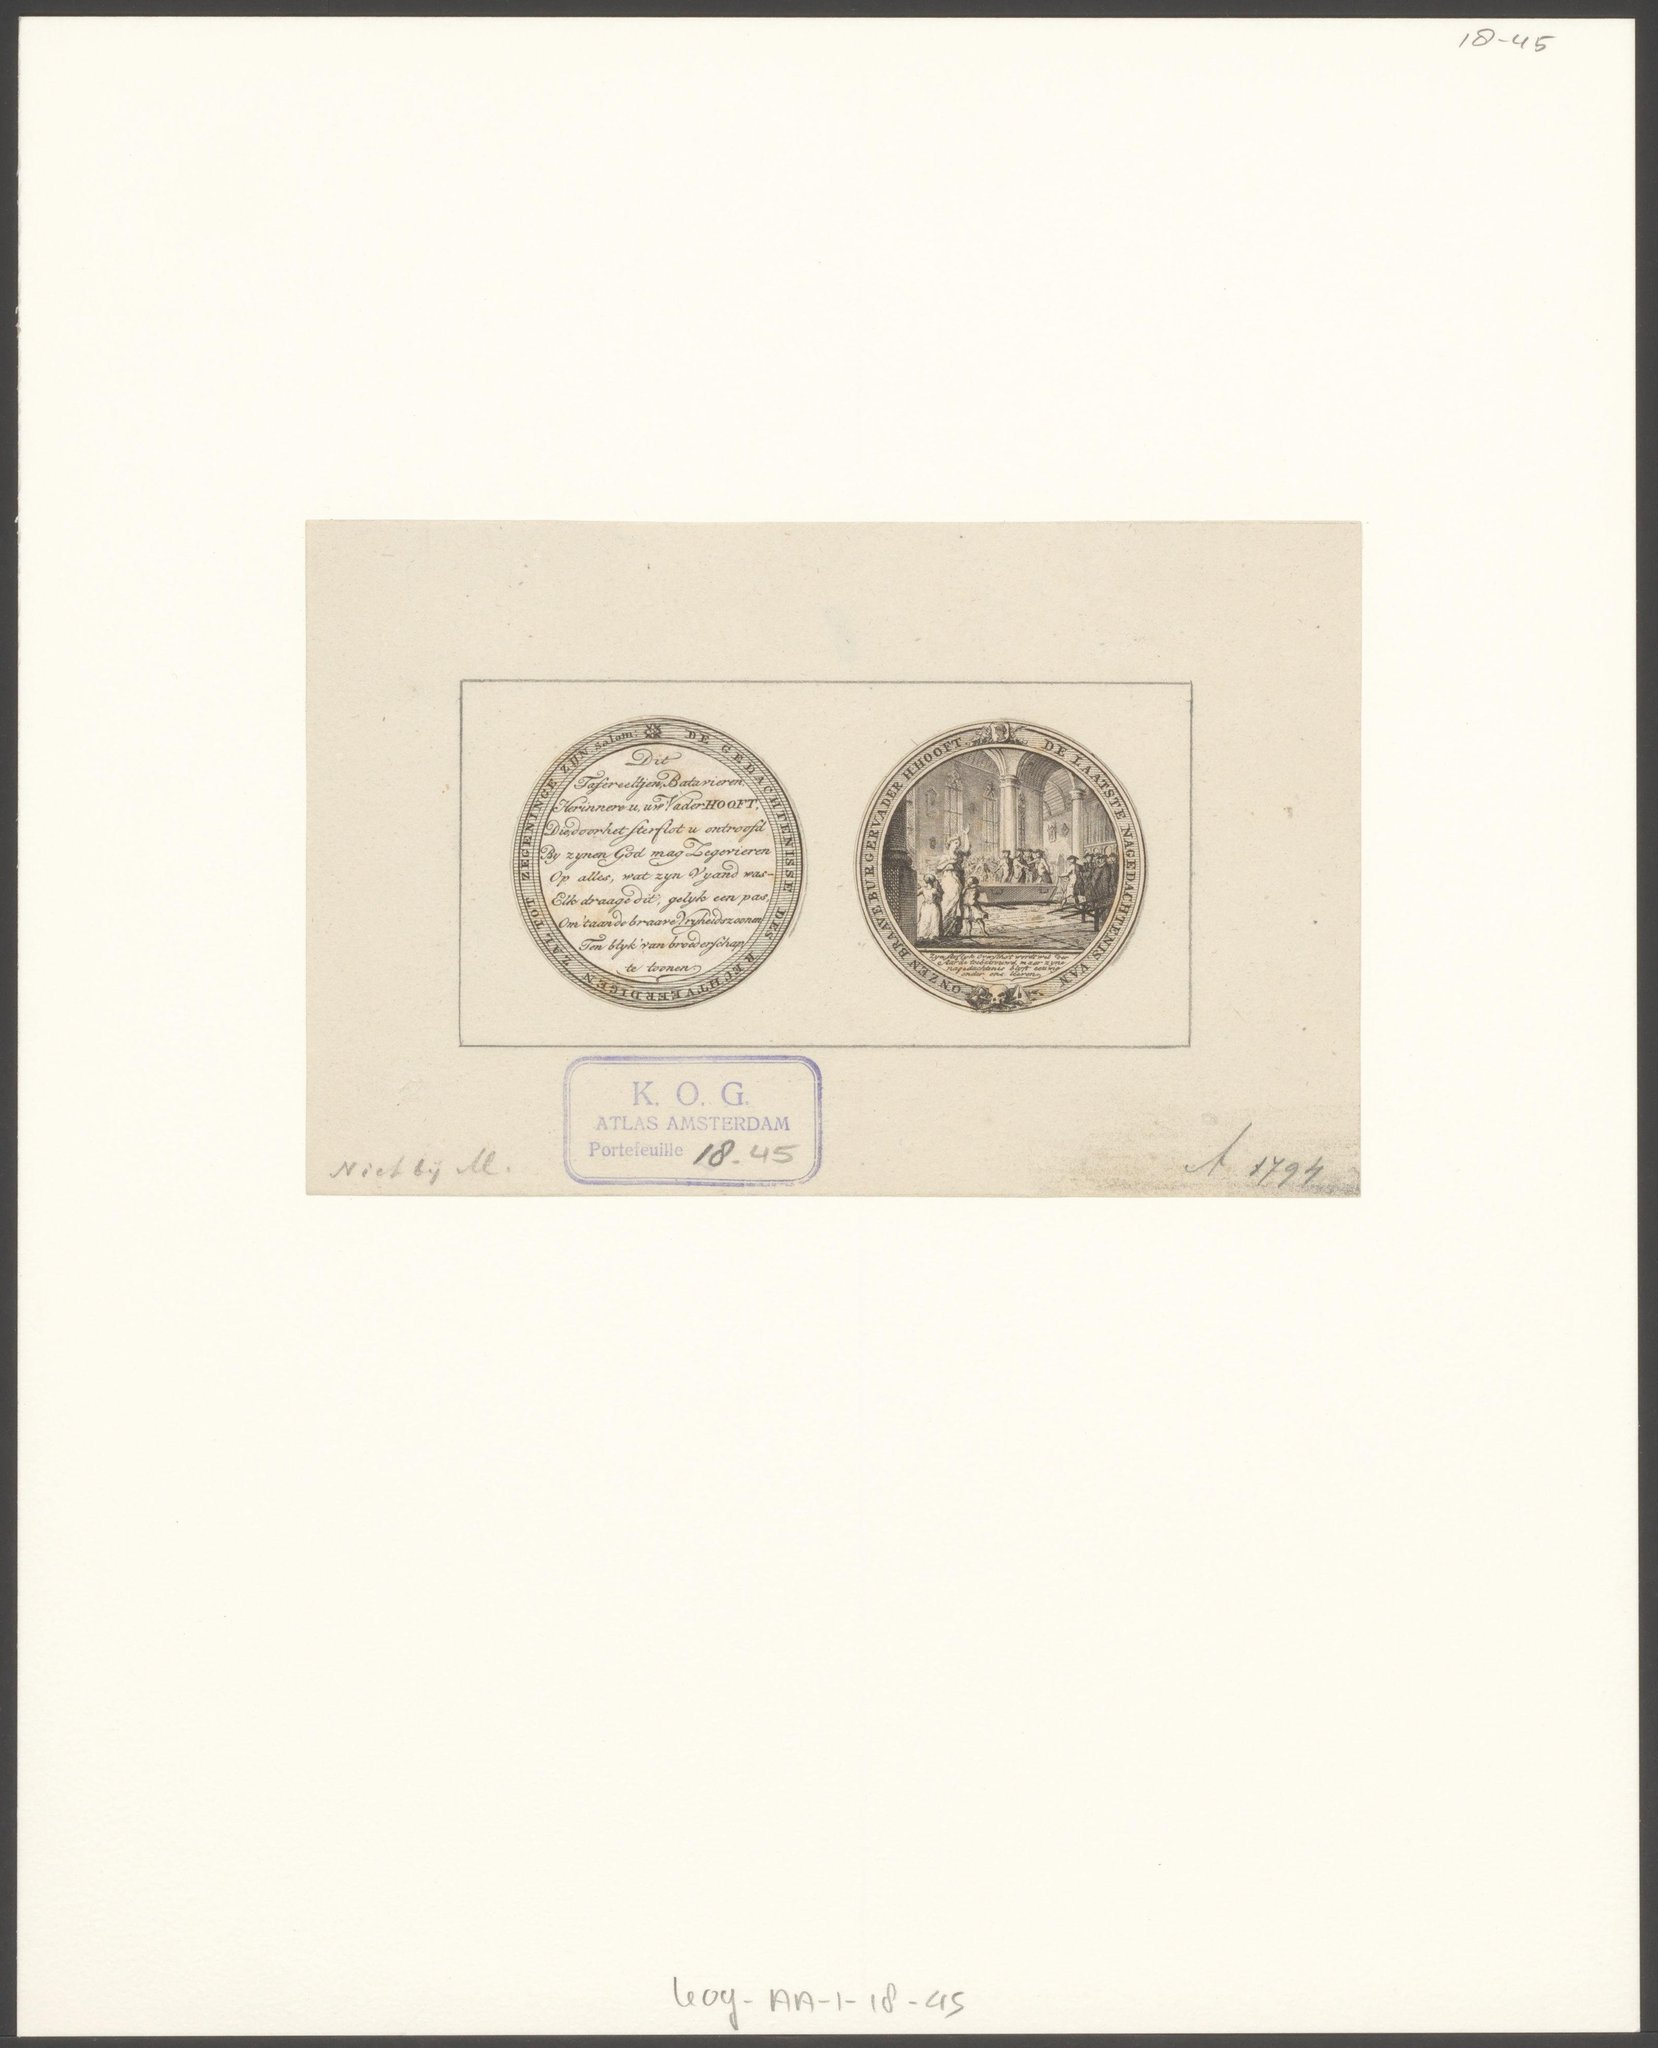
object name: medal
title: De Laatste Nagedachtenis van onzen Braave Burgervader H. Hooft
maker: Anonymous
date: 1794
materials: paper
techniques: etching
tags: amsterdam, mayor, hendrik danielsz. hooft, patriot (revolutionary)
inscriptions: collector's mark: ‘18.45’ Lugt 1641b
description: Onderwerpsrubriek binnen de Atlas Amsterdam: Herinneringen aan regeringsleden en hunne huisgezinnen [voor 1800].